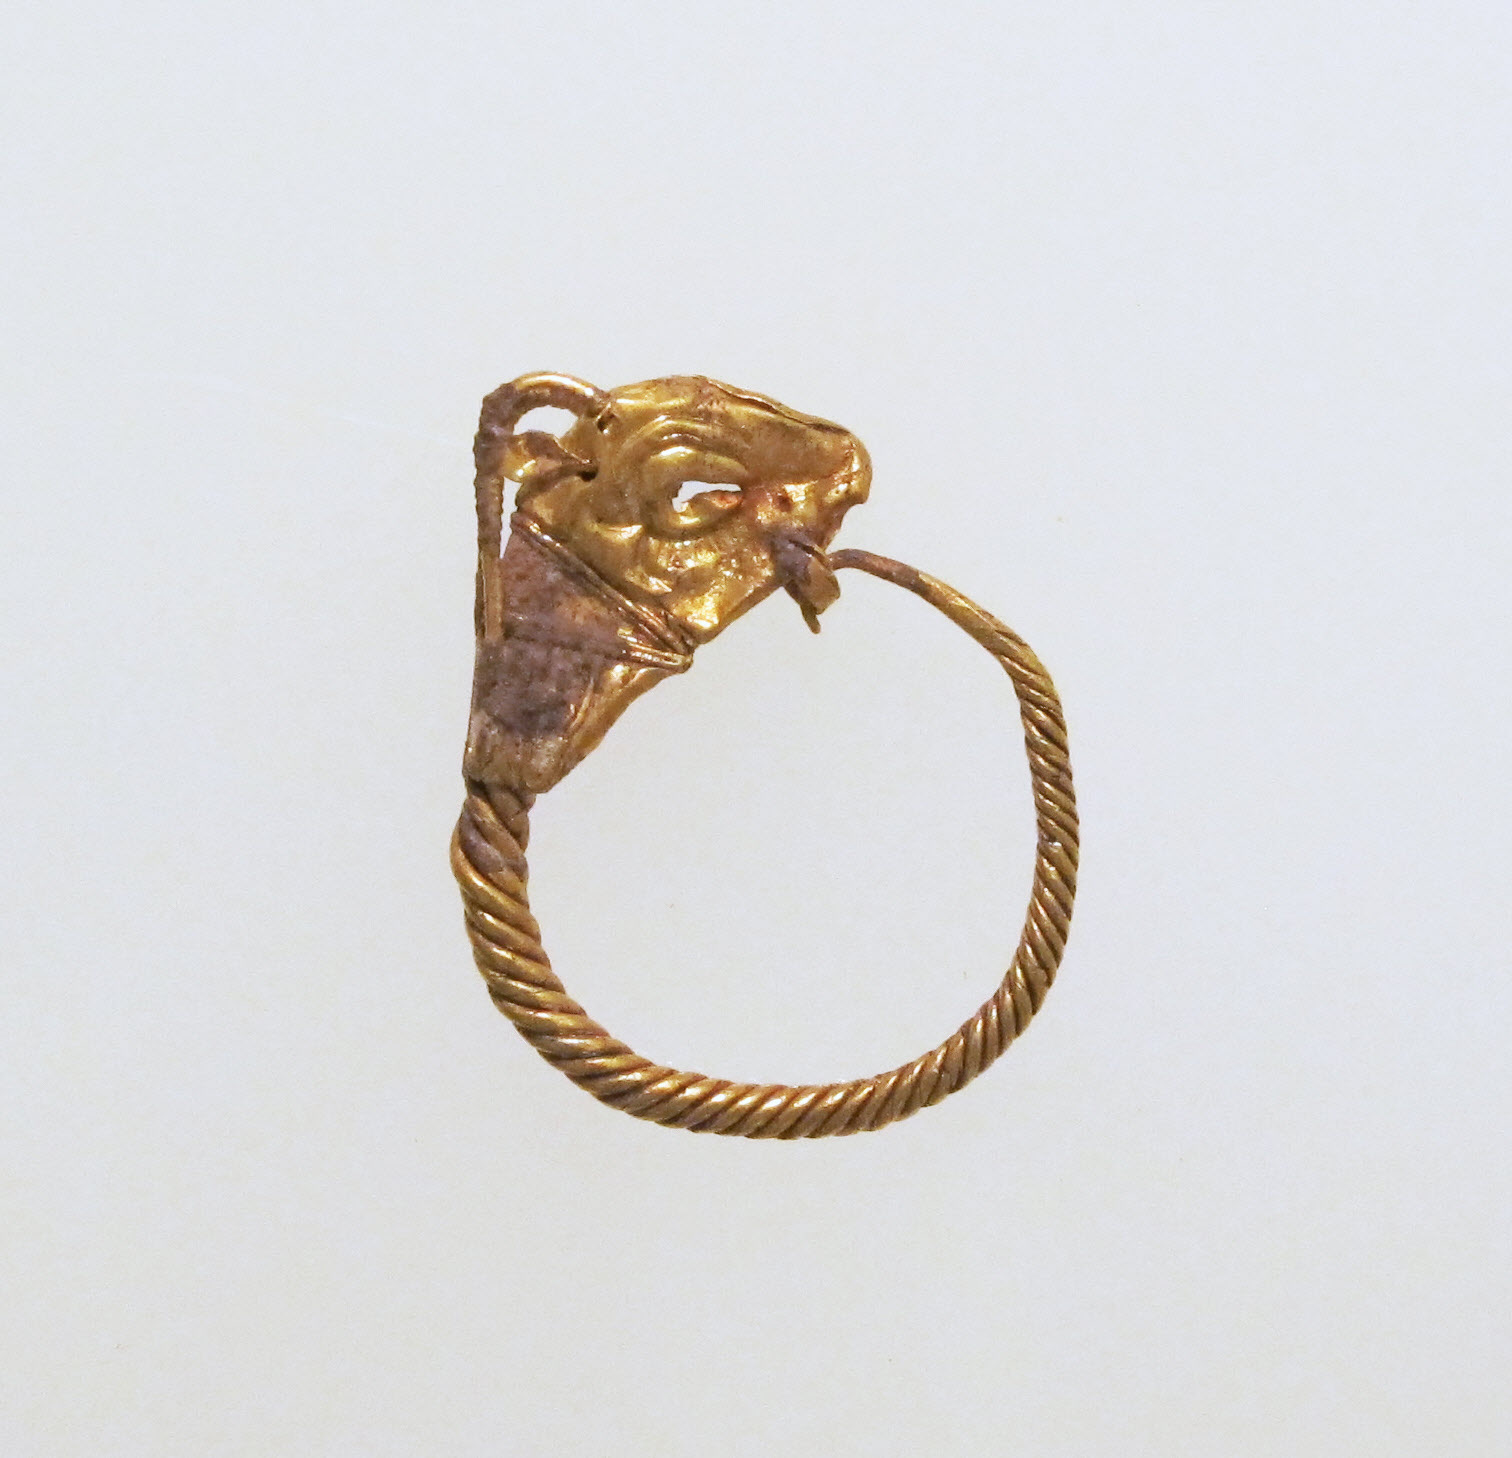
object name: earring with head of goat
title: Gold earring with head of a goat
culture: greek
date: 400-201 BCE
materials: gold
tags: goats